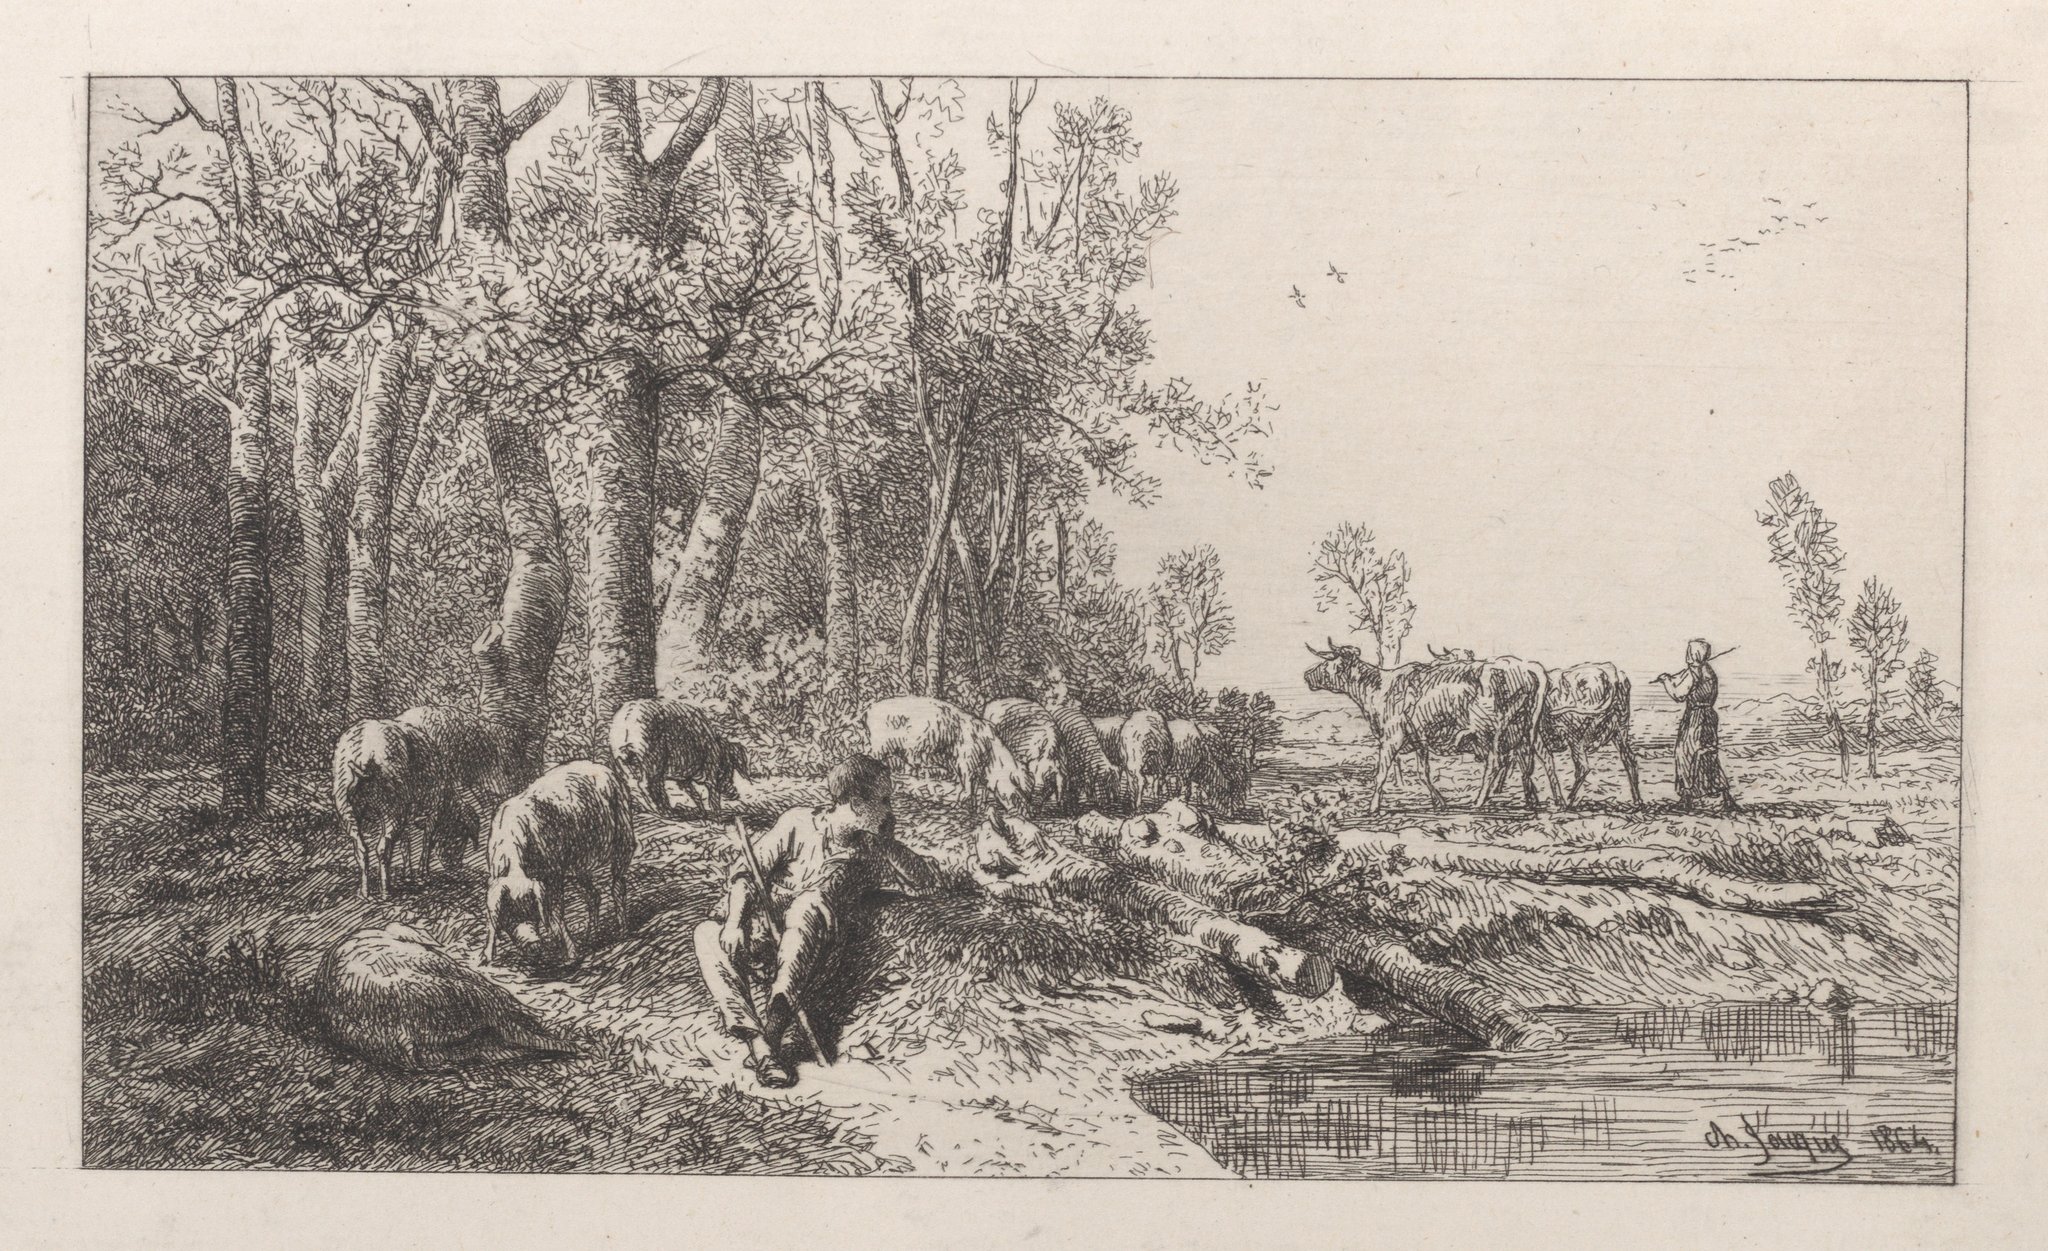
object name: print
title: Winter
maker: charles émile jacque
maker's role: artist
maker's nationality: french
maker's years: 1813-1894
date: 1864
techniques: etching